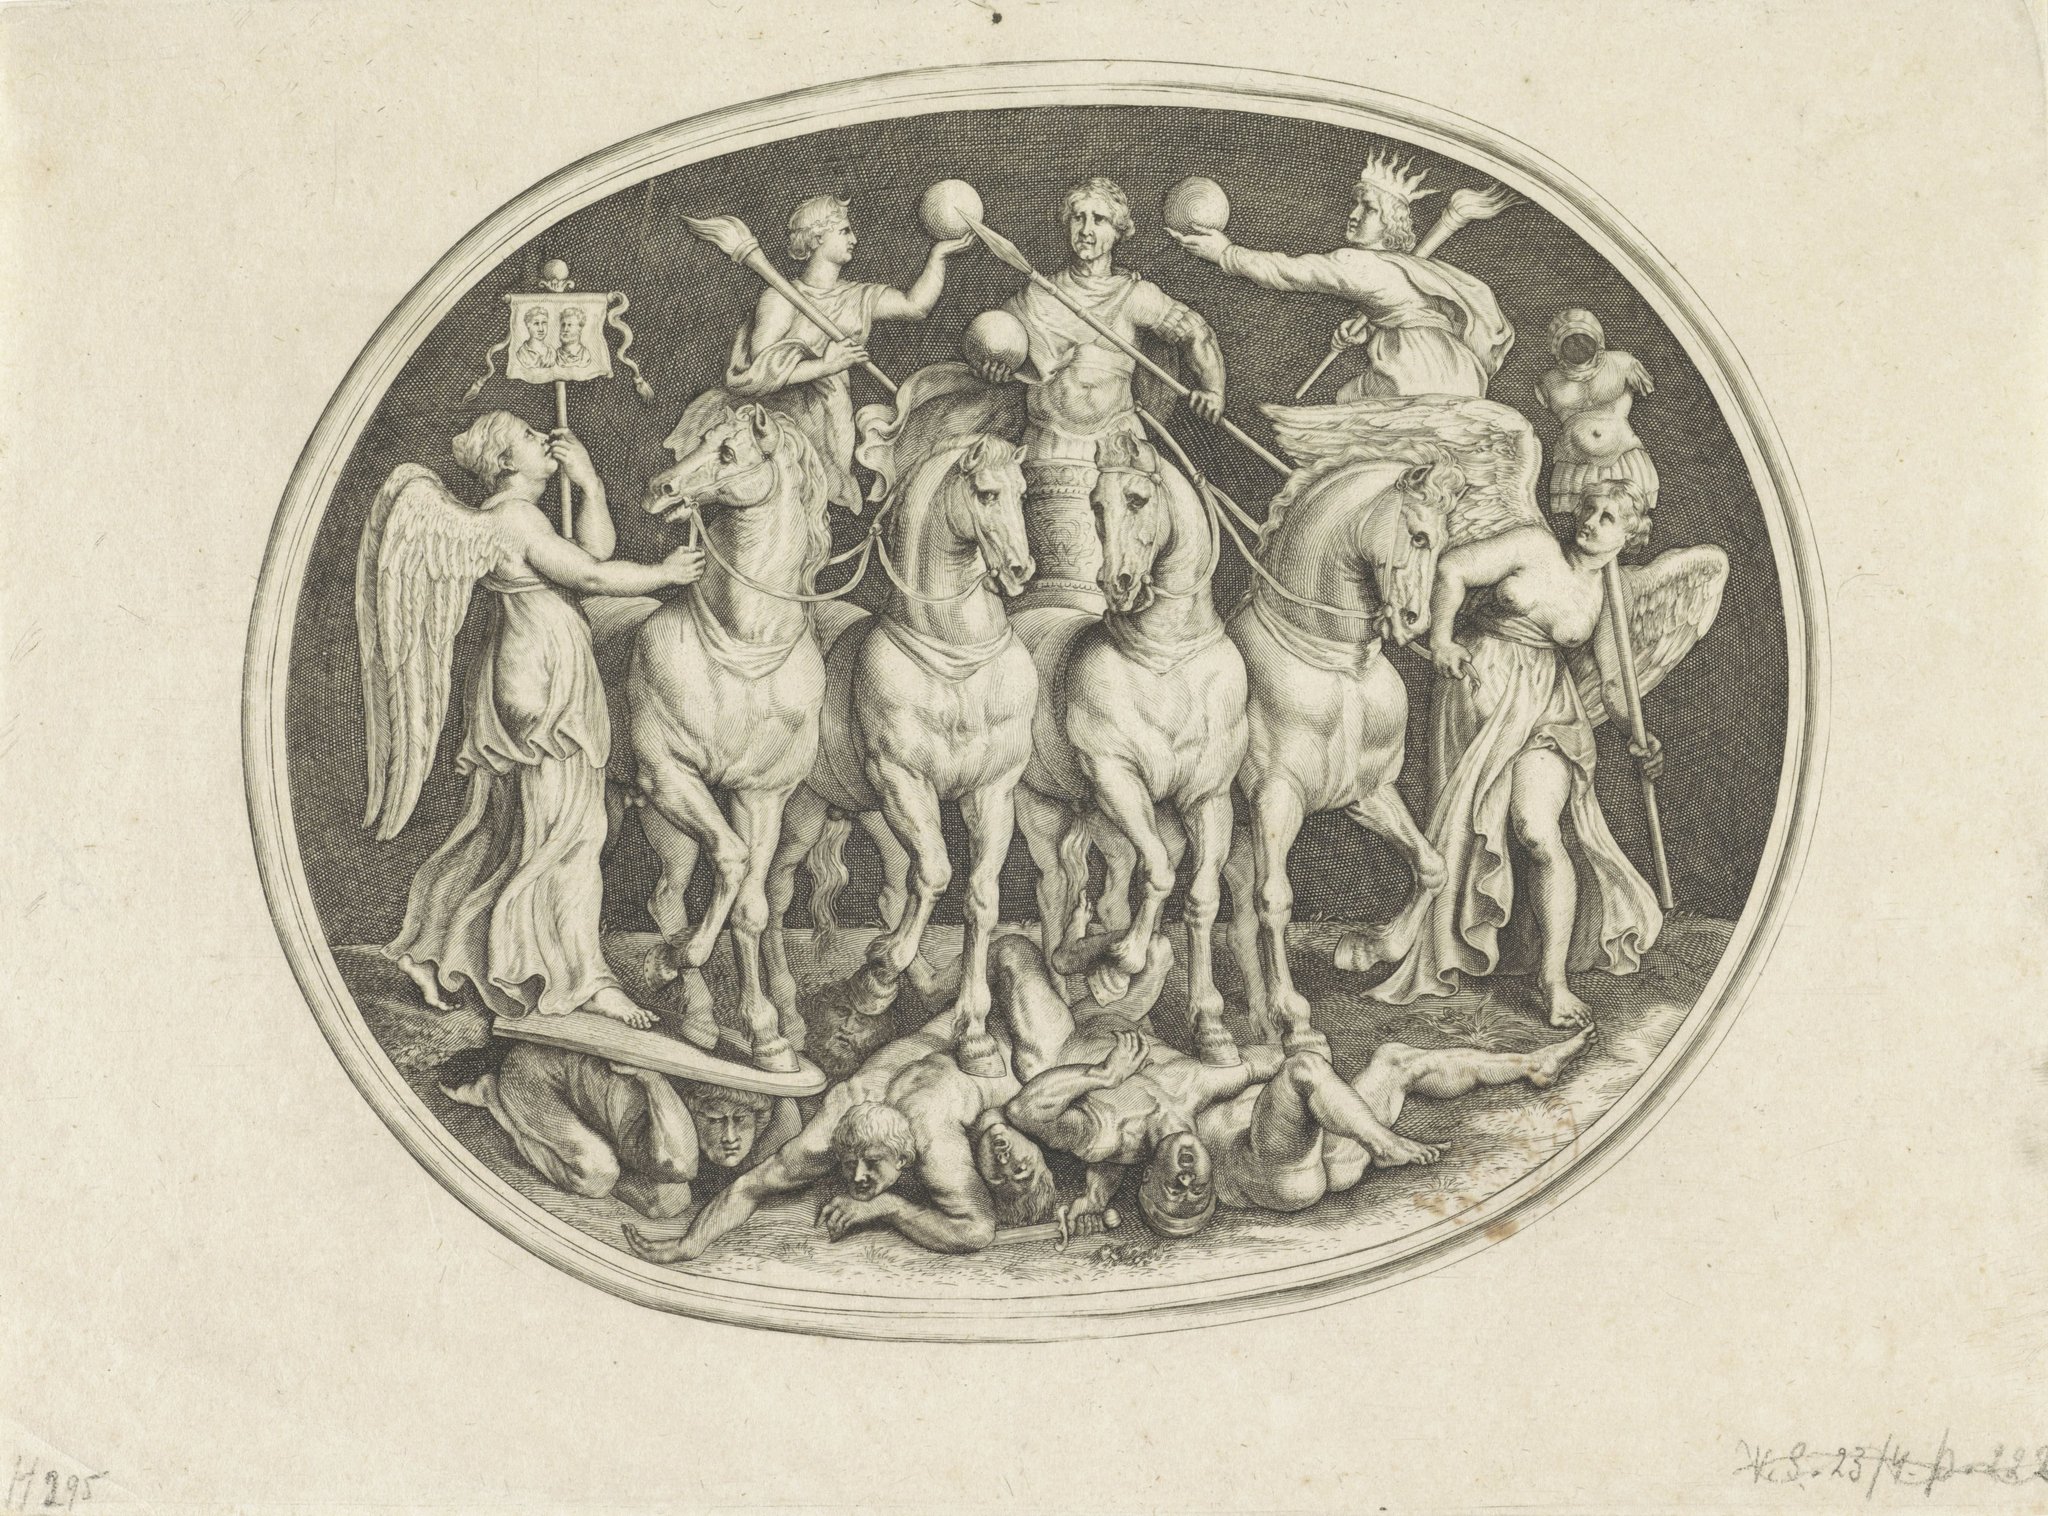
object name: print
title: Allegorische triomf van keizer Licinius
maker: lucas vorsterman (i)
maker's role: print maker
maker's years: 1595-1675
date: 1622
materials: paper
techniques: engraving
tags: conqueror triumphing, triumphal entry of victor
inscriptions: collector's mark: Lugt 240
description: Prent uit de serie 'Varie Figueri de Agati Antique' naar Peter Paul Rubens, van in totaal negen prenten waarvan vermoedelijk vijf door Lucas Vorsterman I en vier door Paulus Pontius.